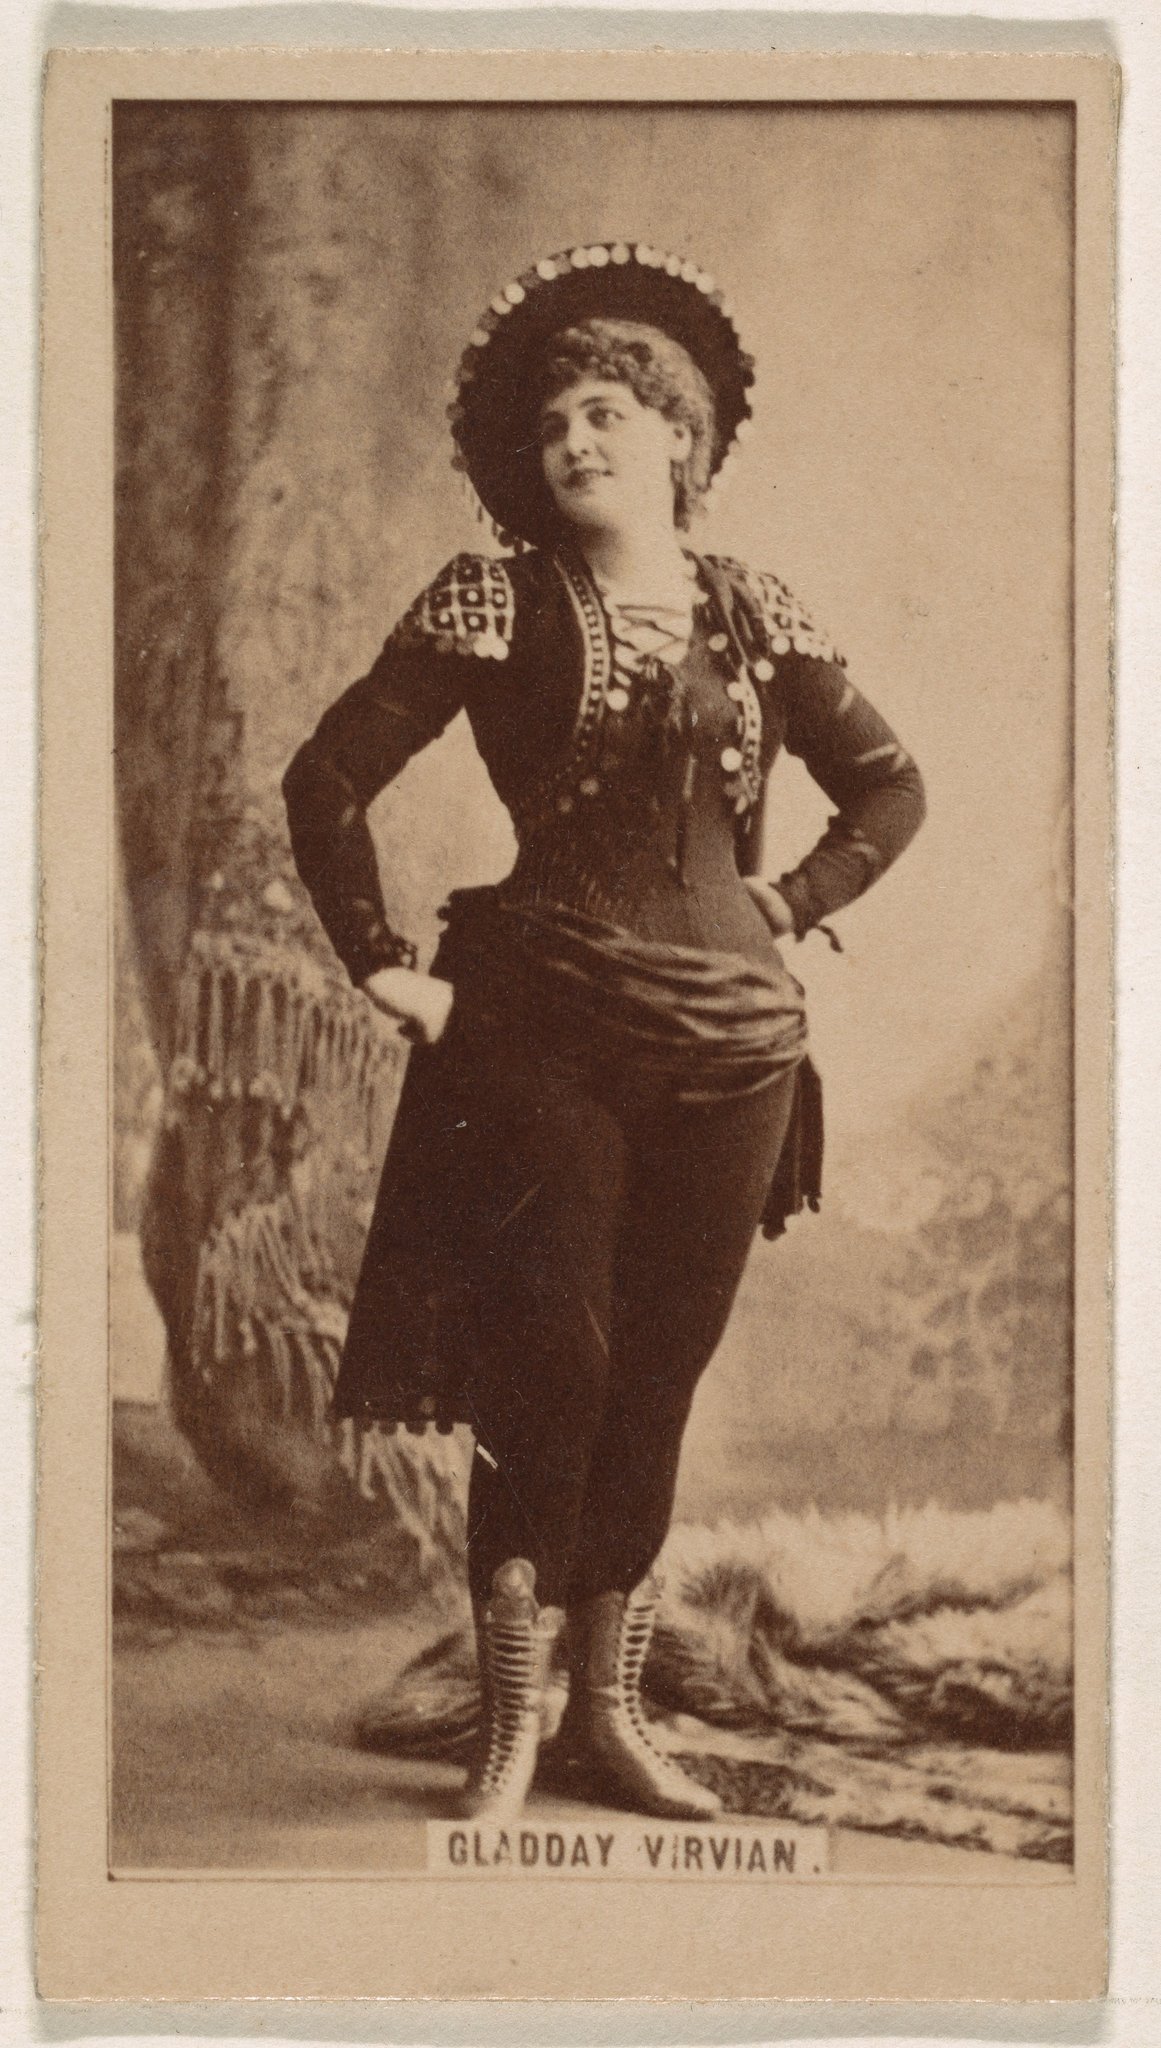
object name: photograph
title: Gladday Virvian, from the Actresses series (N245) issued by Kinney Brothers to promote Sweet Caporal Cigarettes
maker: kinney brothers tobacco company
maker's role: publisher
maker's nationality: american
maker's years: 1869-2011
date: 1890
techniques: albumen silver print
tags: portraits,women,actresses